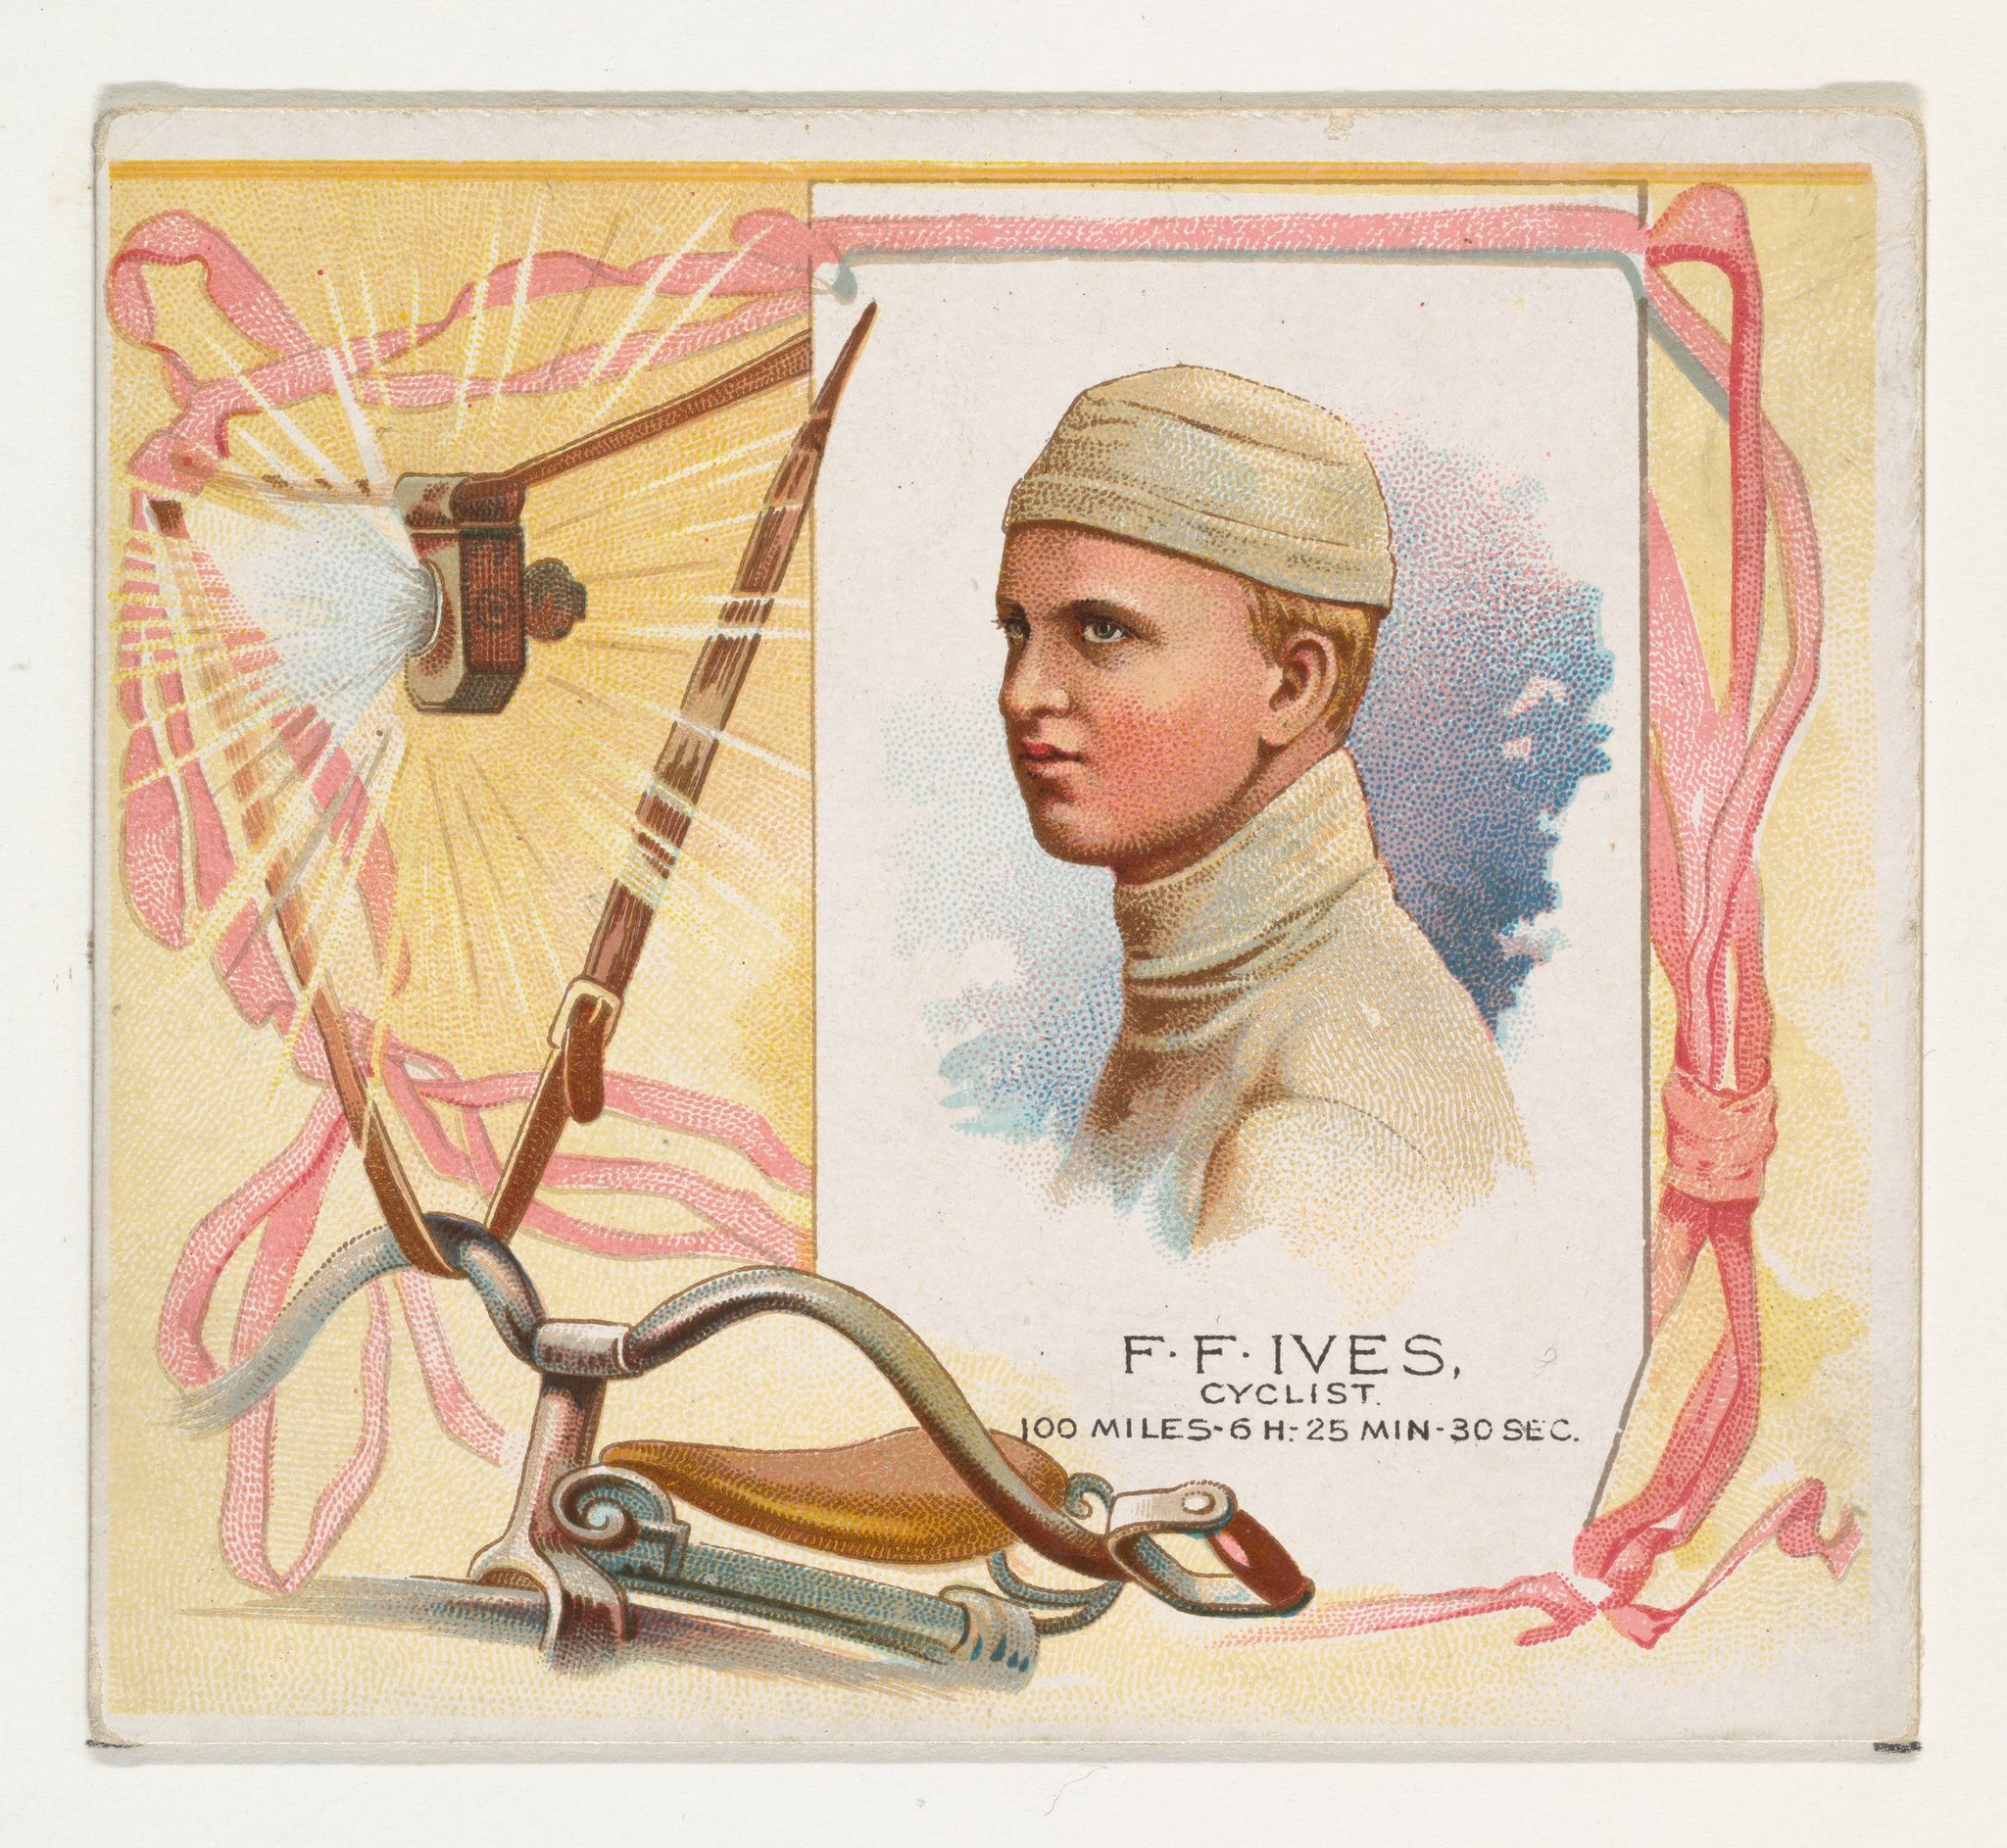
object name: print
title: F.F. Ives, Cyclist, from World's Champions, Second Series (N43) for Allen & Ginter Cigarettes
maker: allen & ginter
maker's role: publisher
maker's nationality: american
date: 1888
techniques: lithography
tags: men,profiles,athletes